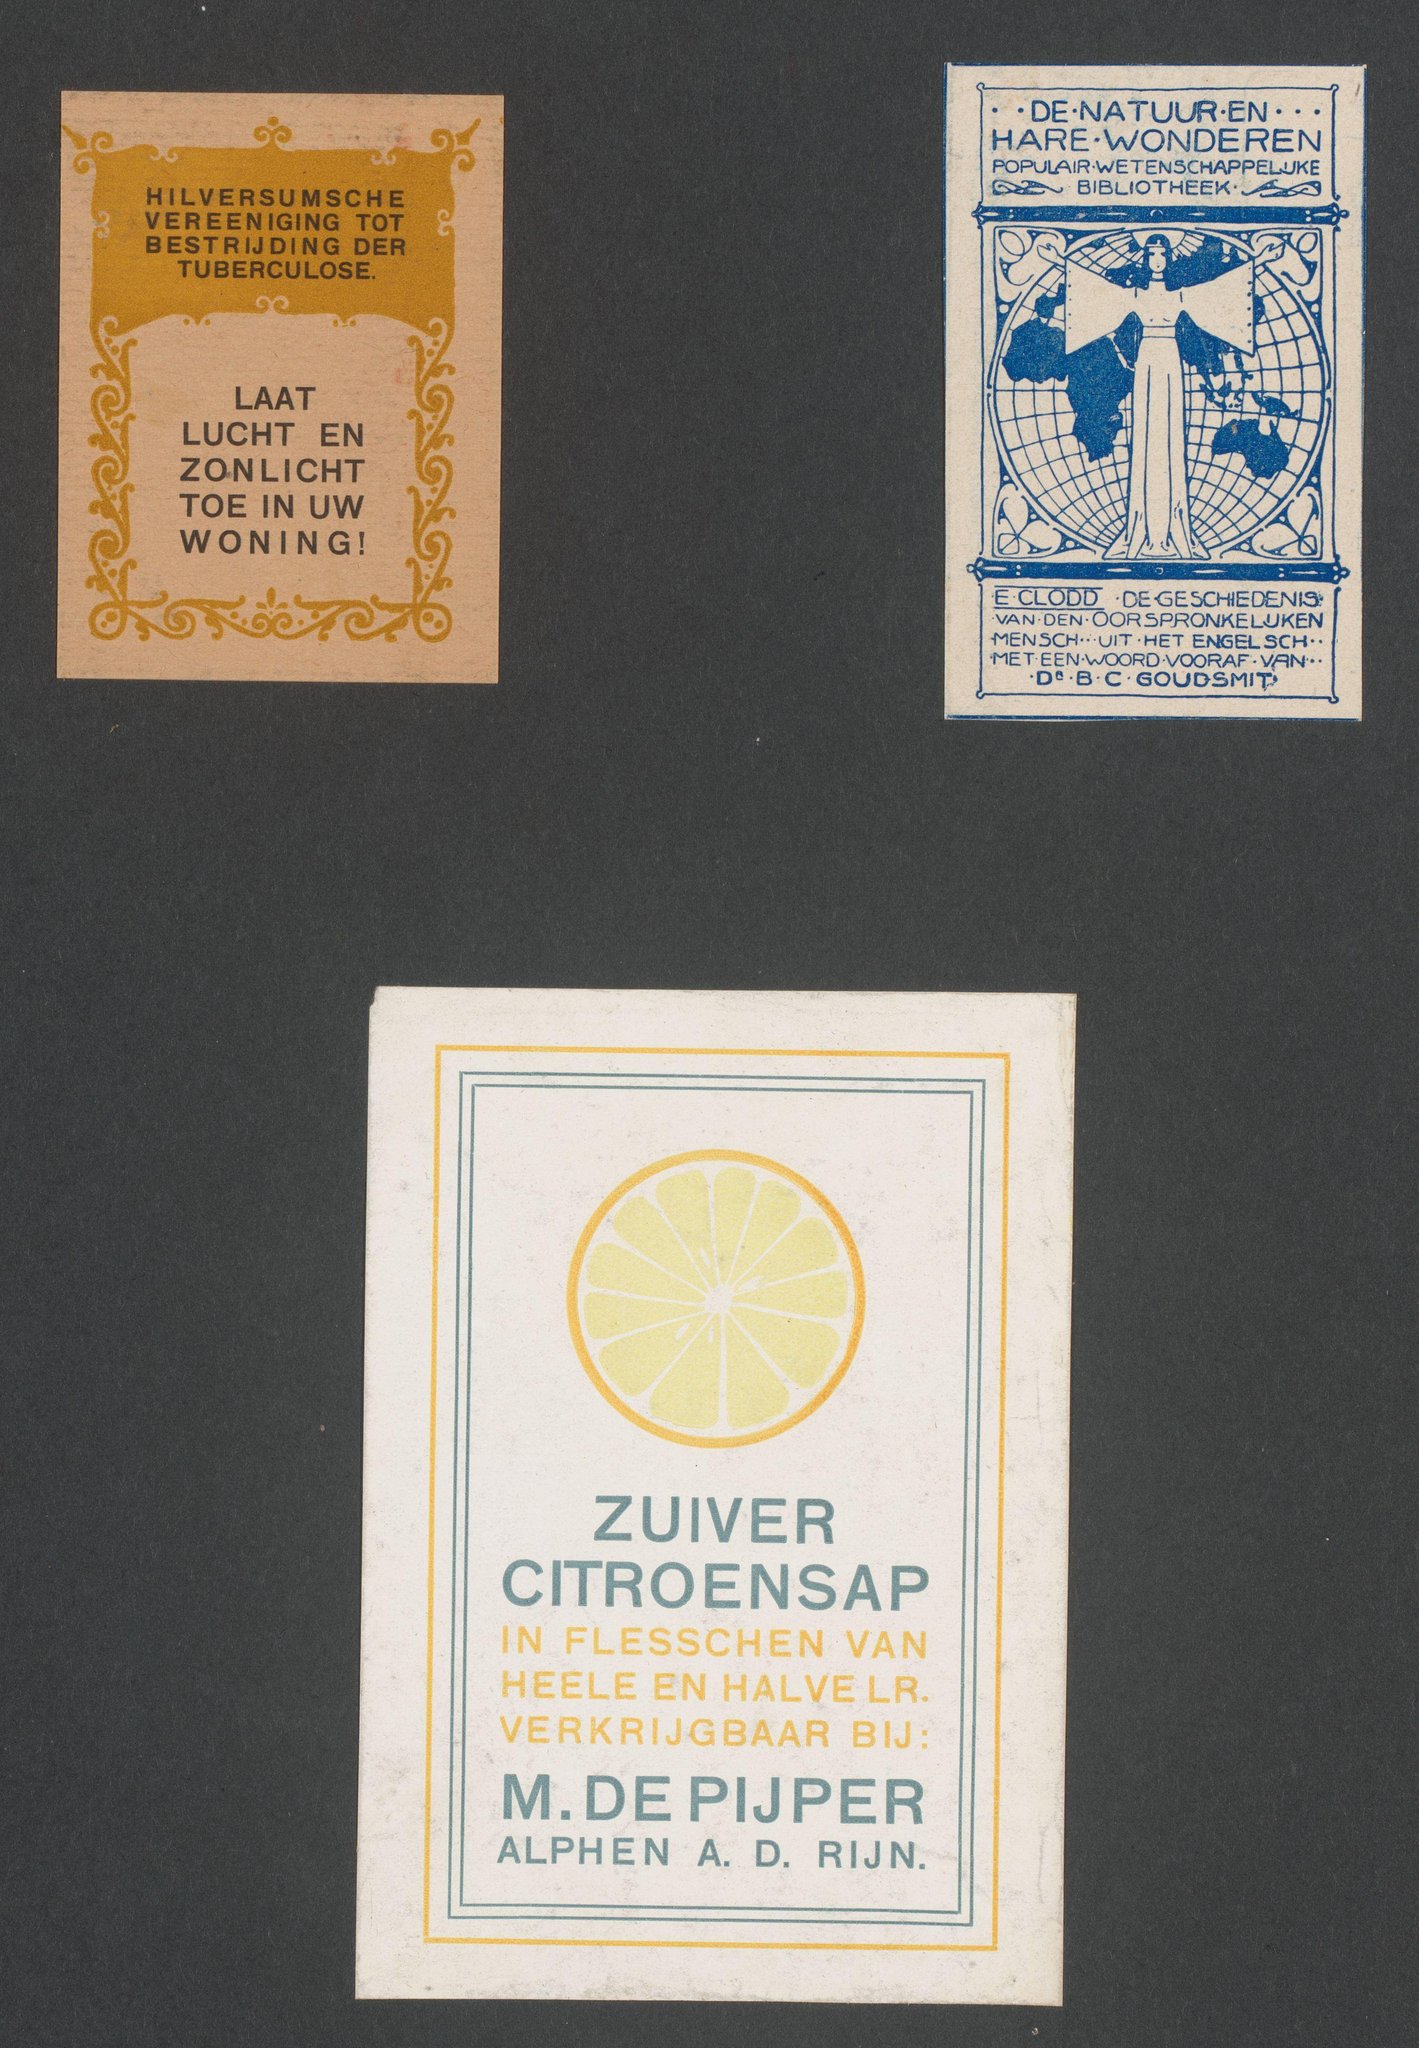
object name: study for binding design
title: Advertentie van de Hilversumsche Vereeniging tot bestrijding der tuberculose, advertentie voor zuiver citroensap van M. de Pijper en een bandontwerp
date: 1884-1952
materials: paper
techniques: printing block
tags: coat of arms (as symbol of the state, etc.), crown (symbol of sovereignty)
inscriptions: number: ‘No14.15’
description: Bandontwerp voor: Clodd, Edward. De geschiedenis van den oorspronkelijken mensch. Zutphen: W.J. Thieme & Cie, 1897. De publicatie maakt deel uit van een reeks met de titel: De natuur en hare wonderen. Populair-wetenschappelijke bibliotheek.